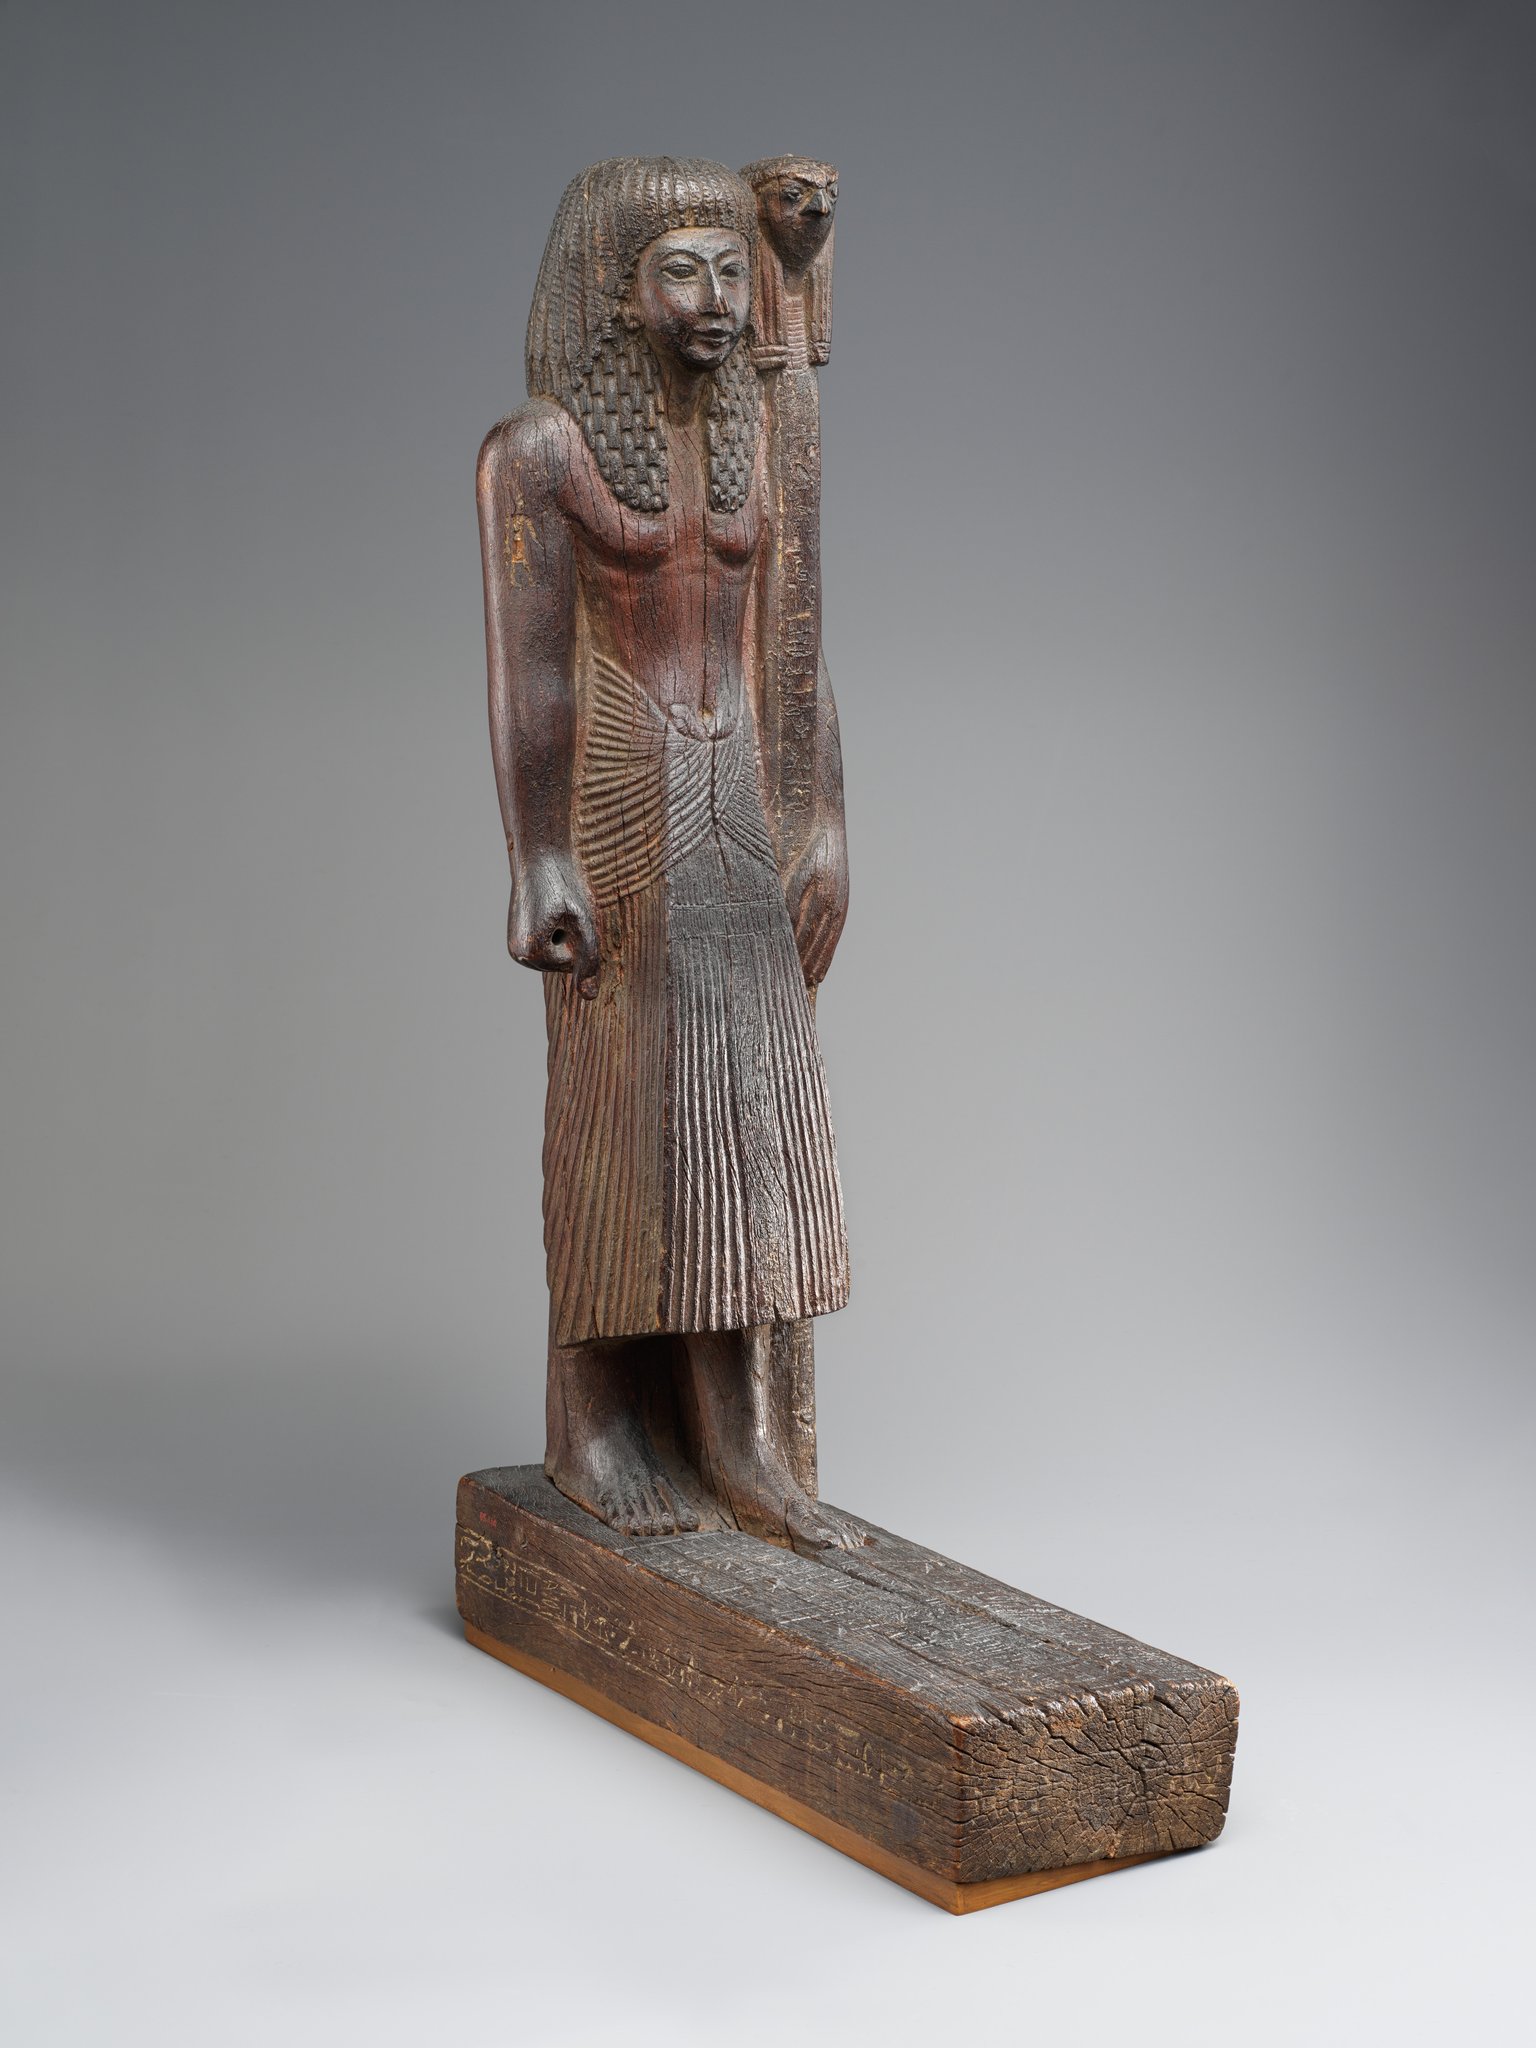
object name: statue, kary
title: Statuette of Kary carrying a standard of Horus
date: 1304-1237 BCE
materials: wood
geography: upper egypt, thebes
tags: falcons,men